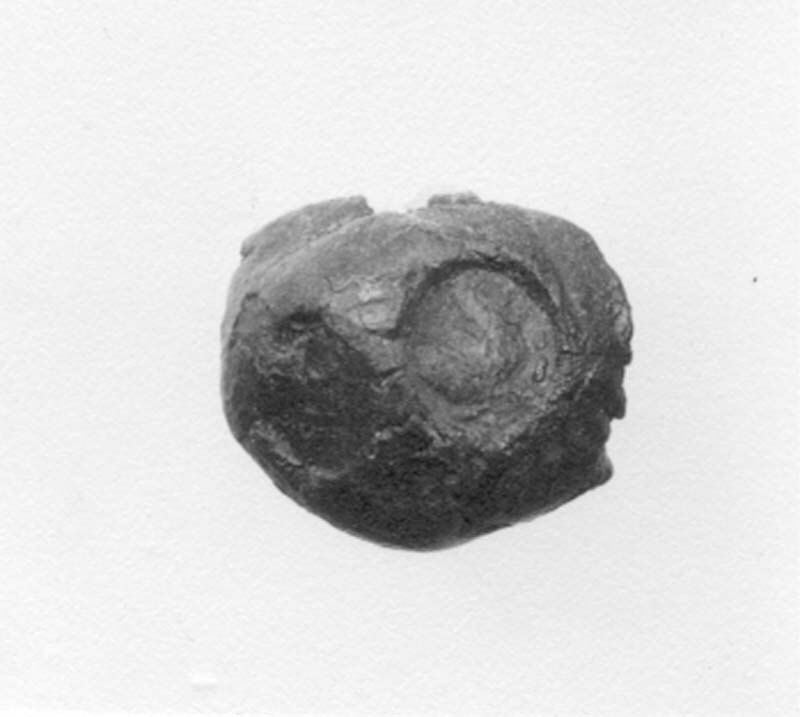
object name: sealing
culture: sasanian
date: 601-700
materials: clay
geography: iran